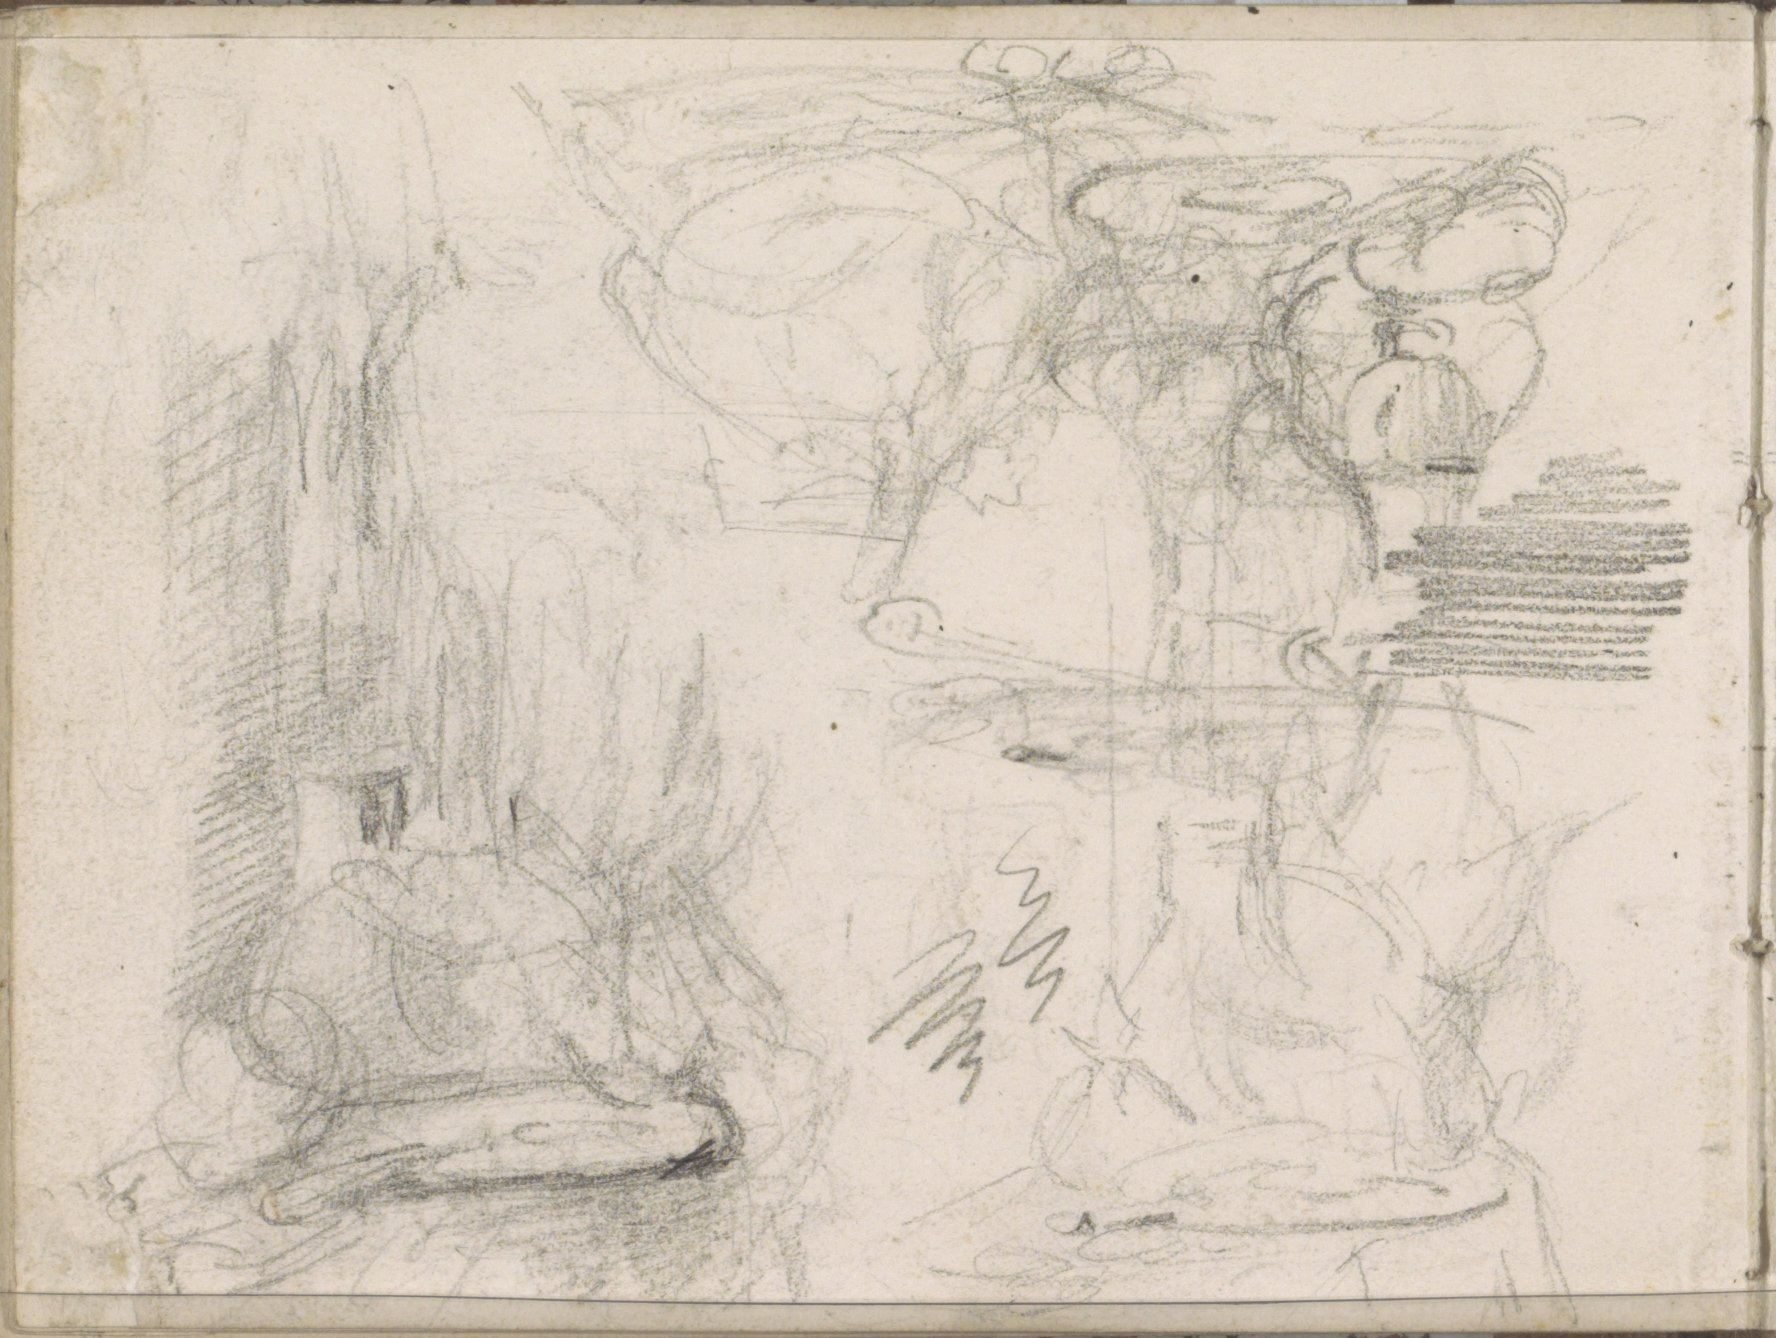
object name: sketchbook leaf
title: Stillevens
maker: maria vos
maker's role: draughtsman, painter, print maker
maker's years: 1824-1906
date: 1834-1906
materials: paper, pencil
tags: still life of related objects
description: Blad 21 verso uit een schetsboek met 21 bladen.